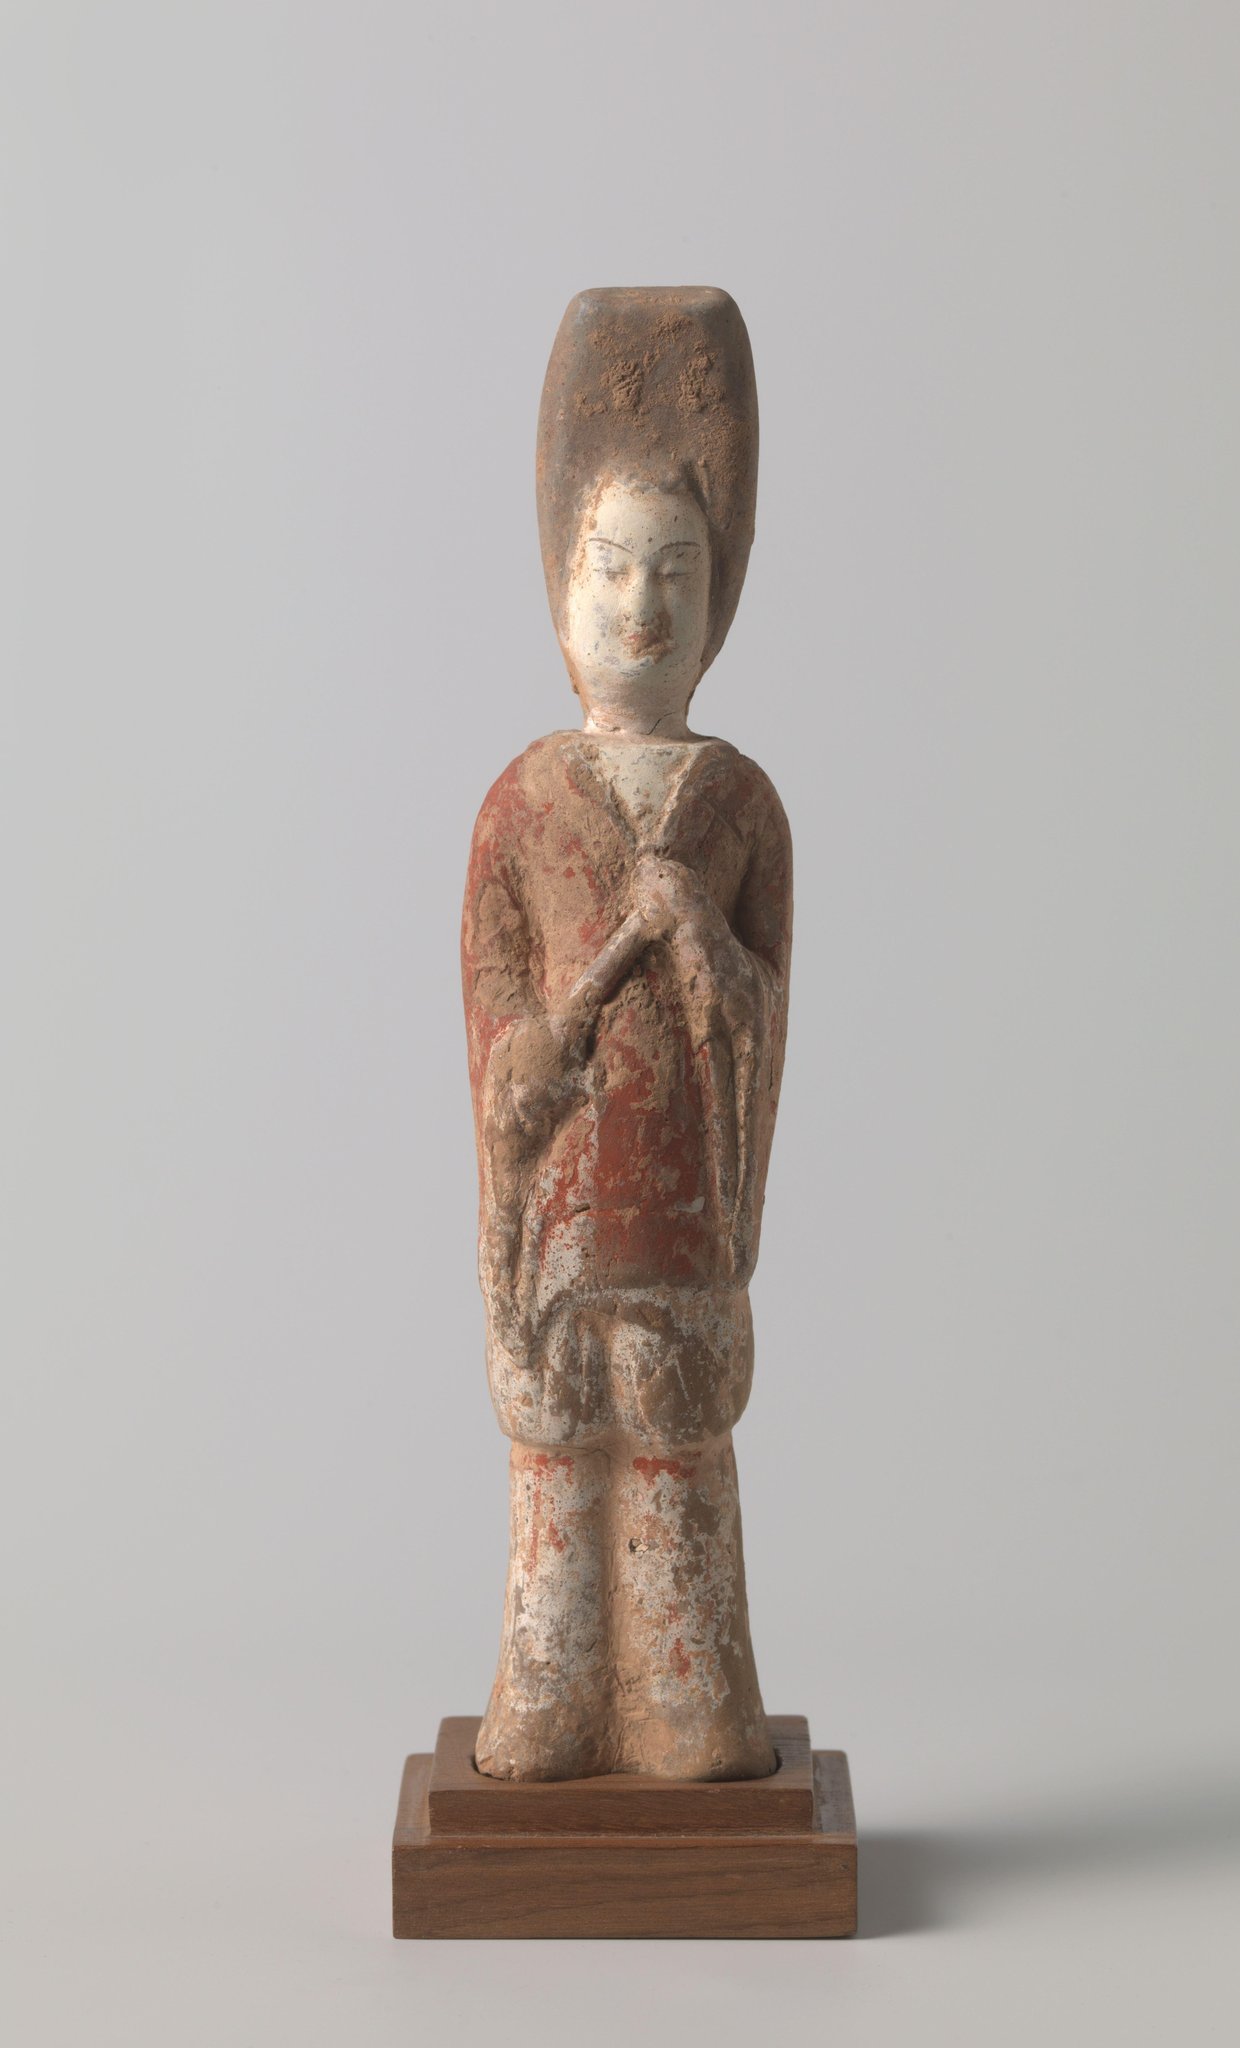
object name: tomb figure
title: Stand of a funeral figure in the shape of a woman with a flute[?]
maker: Anonymous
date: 220-589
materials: paint, wood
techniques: forming, turning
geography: china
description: Staande graffiguur, musicienne, op een los houten voetstuk. De figuur is gekleed in een rood gewaad met V-hals en wijde mouwen en heeft een hoog opgewerkt kapsel. De beschildering is in rood, zwart en wit. Zij houdt een fluit(?) in de hand.